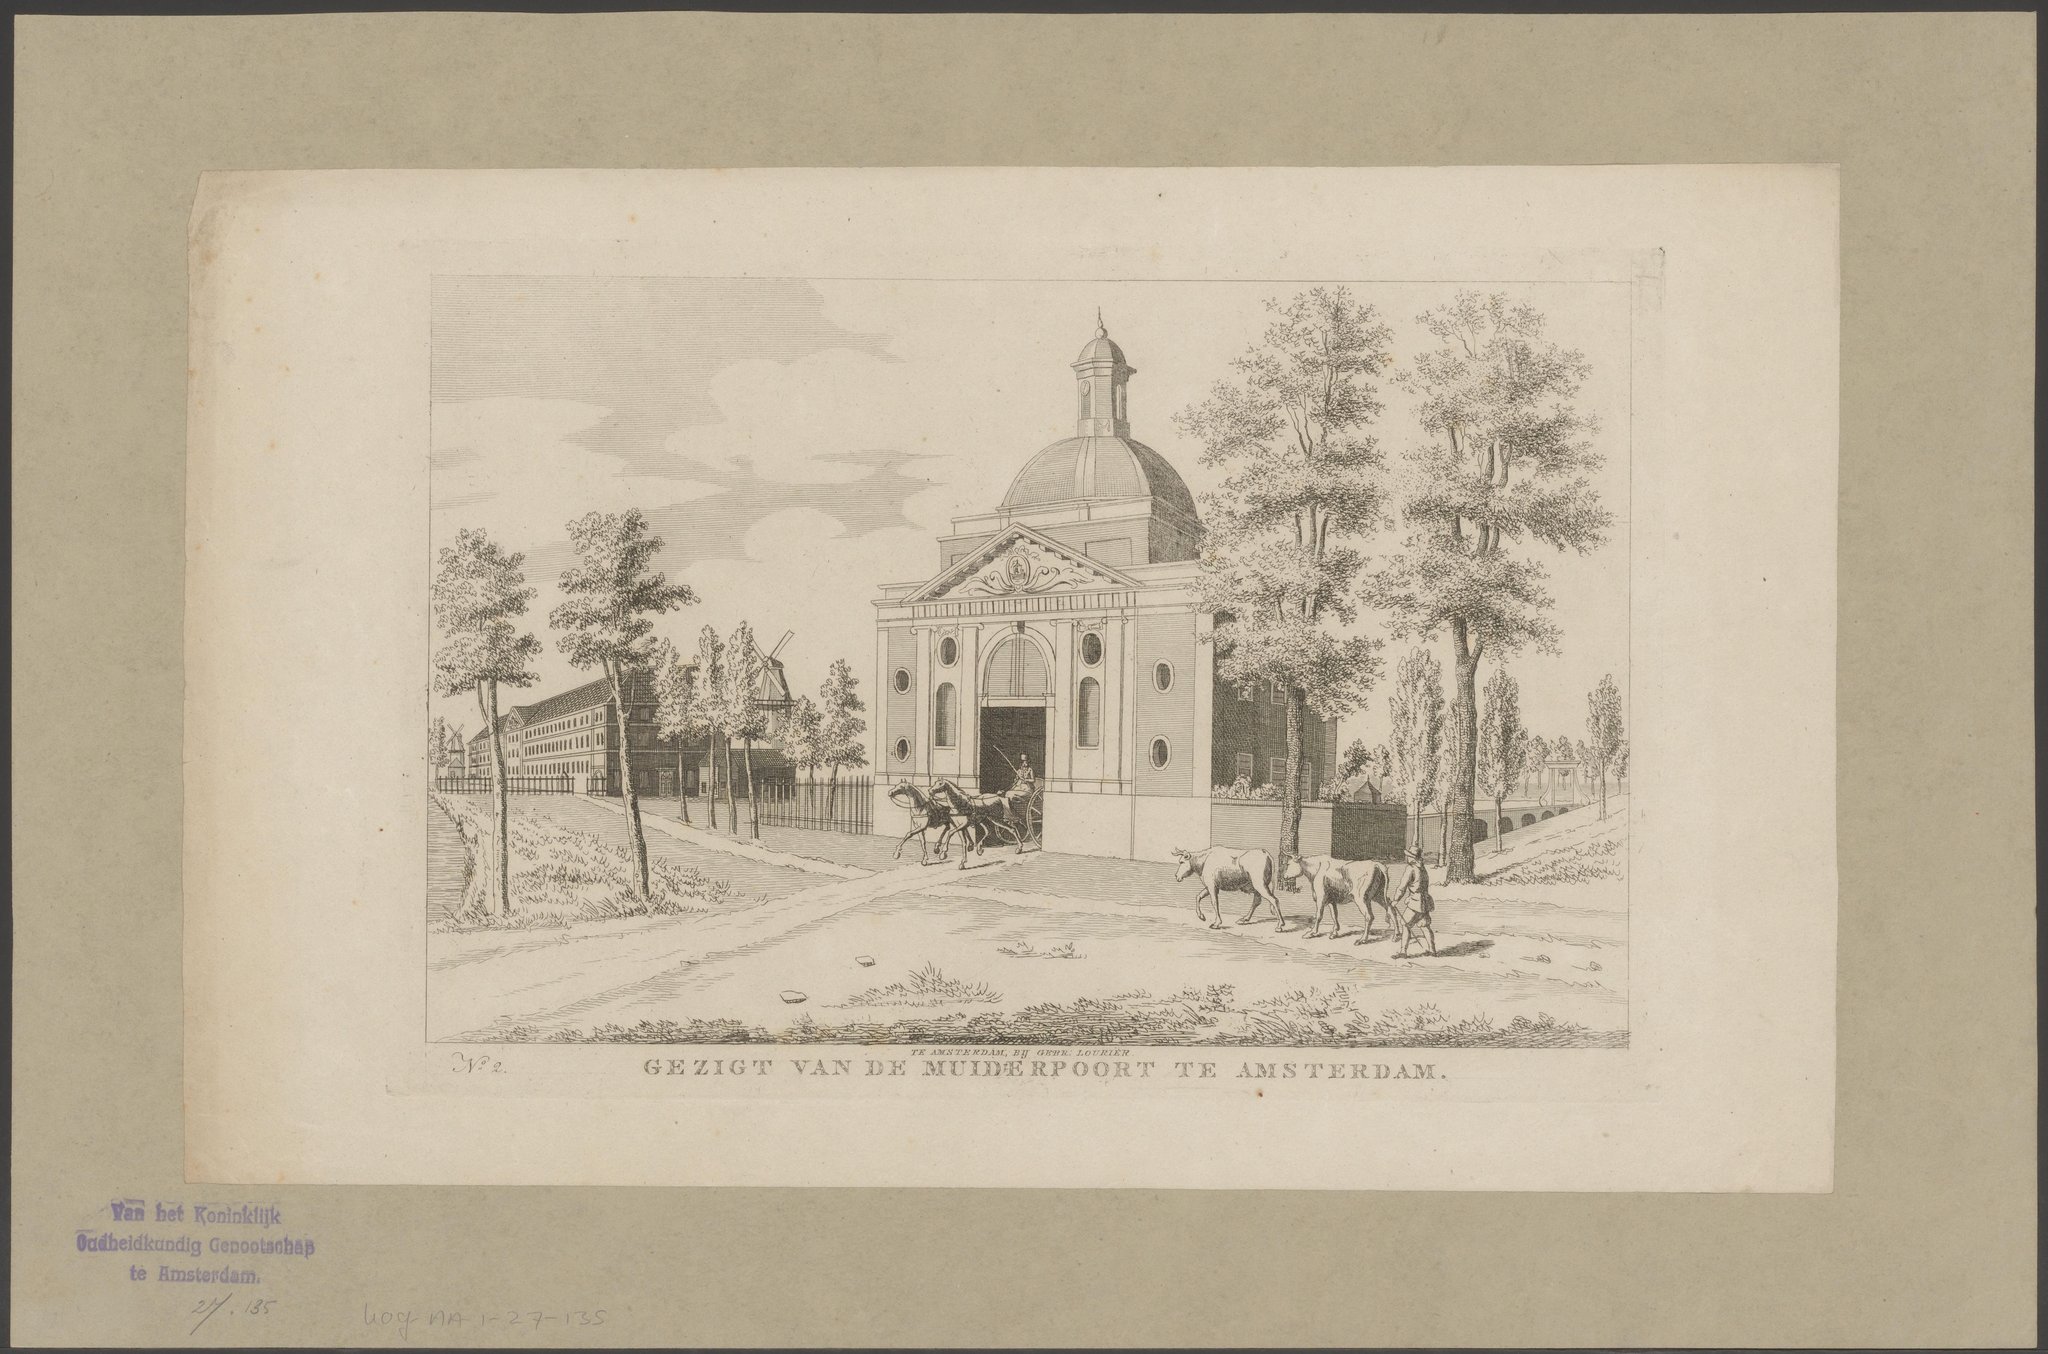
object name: print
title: Koets rijdt door de Tweede Muiderpoort te Amsterdam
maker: Anonymous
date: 1816-1832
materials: paper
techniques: engraving, etching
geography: amsterdam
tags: cow, road, path, windmill, city-gate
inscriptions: collector's mark: ‘Van het Koninklijk Oudheidkundig Genootschap te Amsterdam’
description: Linksonder genummerd: No. 2. Onderwerpsrubriek binnen de Atlas Amsterdam: Poorten, verzamelbladen, J. Tweede Muiderpoort.